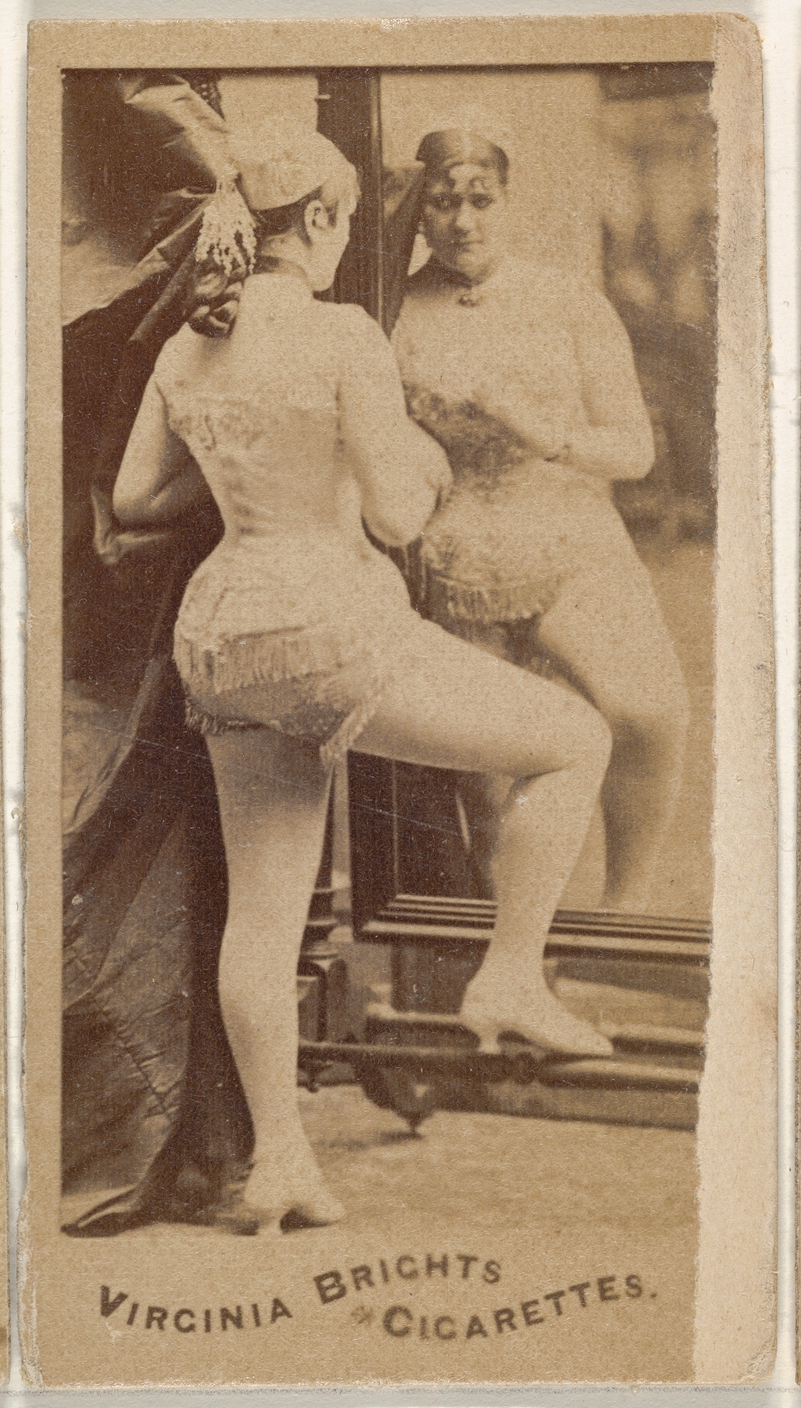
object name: photograph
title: From the Actors and Actresses series (N45, Type 5) for Virginia Brights Cigarettes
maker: allen & ginter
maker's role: publisher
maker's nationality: american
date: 1888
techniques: albumen silver print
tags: portraits,women,actresses,mirrors